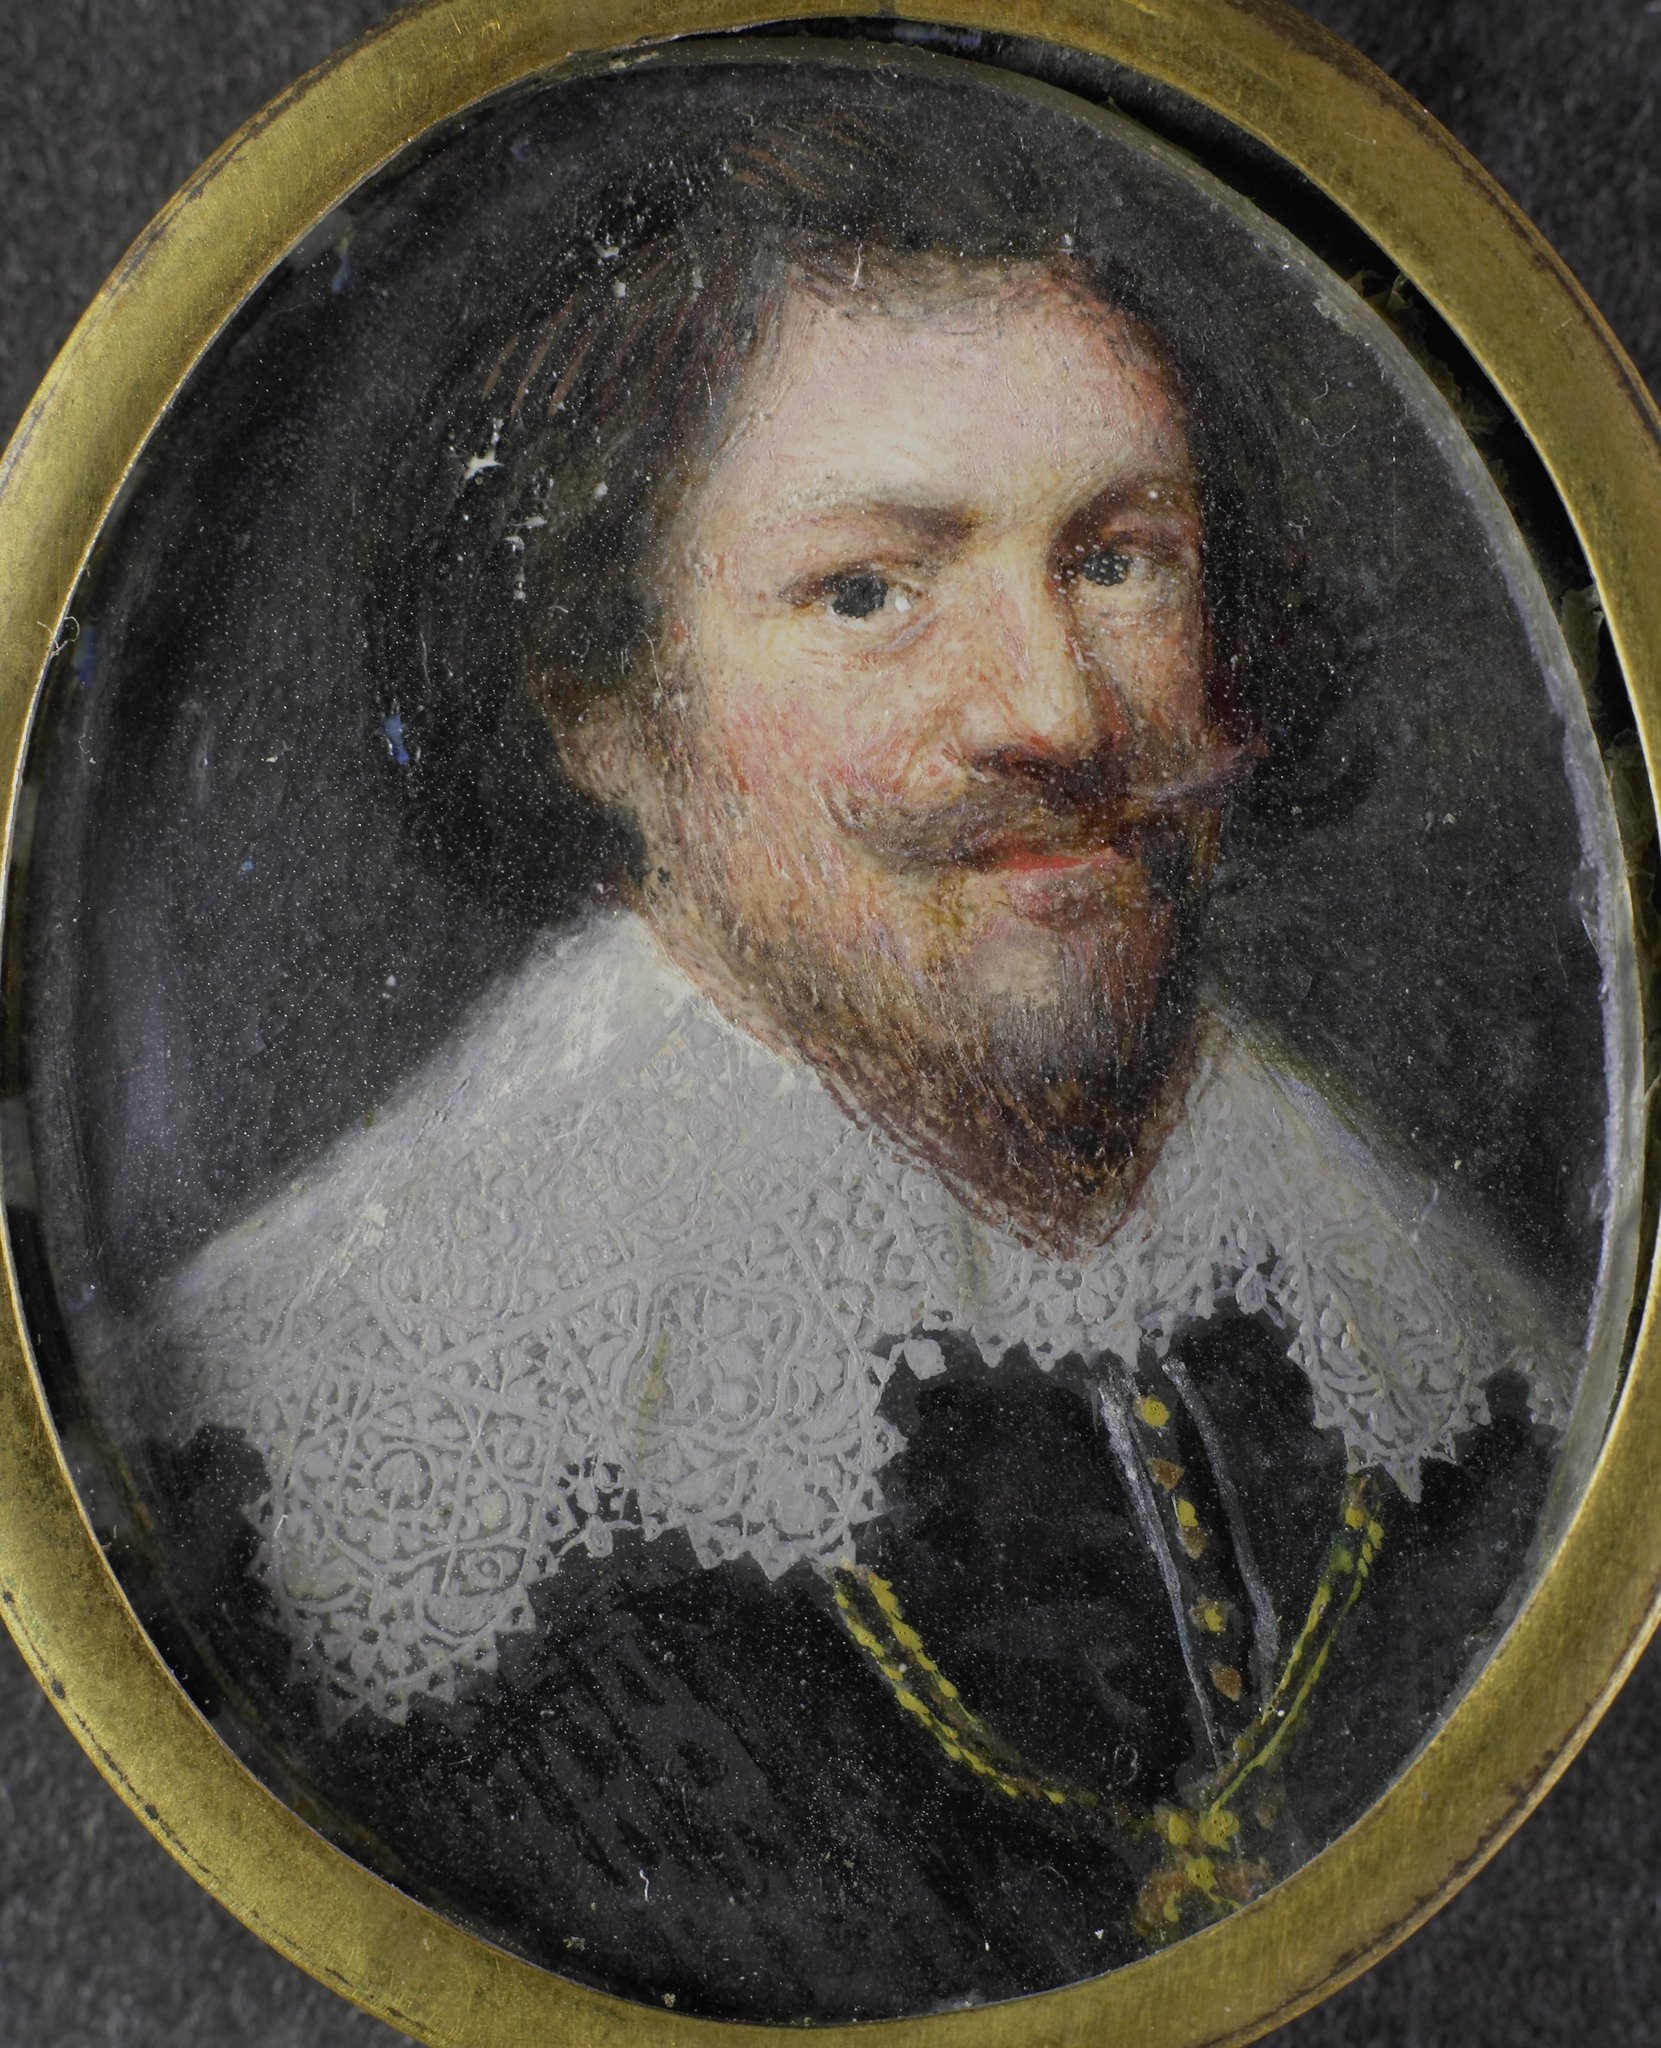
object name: painting, miniature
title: Portret van een man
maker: Anonymous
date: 1635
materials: metal, oil, parchment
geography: netherlands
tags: historical persons not known by name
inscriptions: inscription: ‘.. loving ..g.. van Prins Willem I. Graaf van ..’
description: Portrait of a man. Holland school. Vellum, c. 1635.